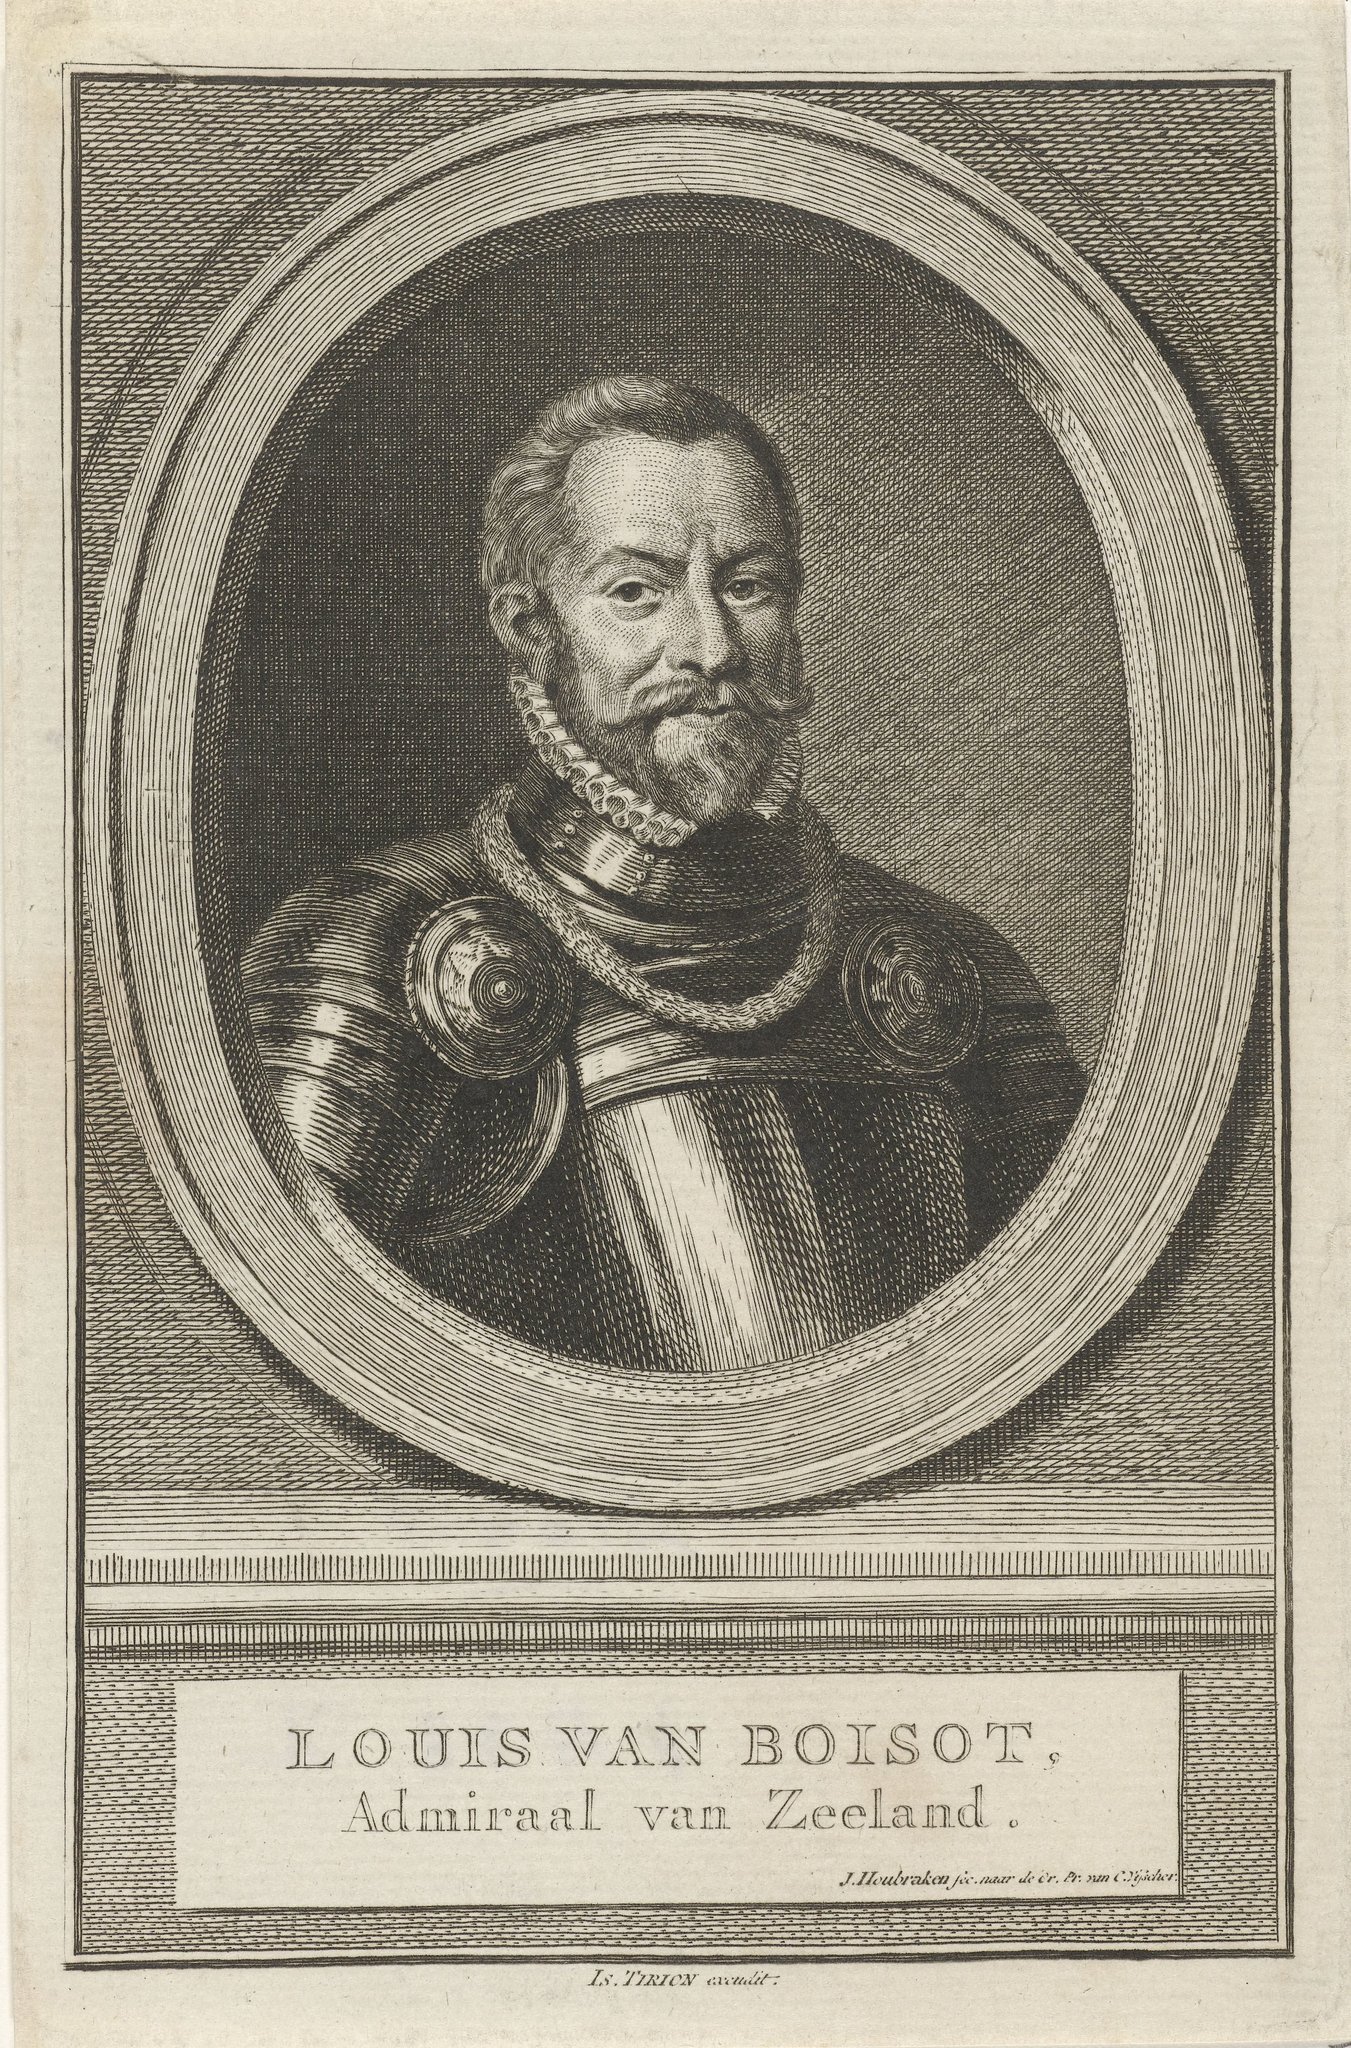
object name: print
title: Portret van Louis de Boisot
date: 1749-1759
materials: paper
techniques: engraving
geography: amsterdam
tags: brussels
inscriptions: collector's mark: Lugt 2228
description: Prent ook gebruikt in: Jan Wagenaar, Vaderlandsche historie, vervattende de geschiedenissen der nu Vereenigde Nederlanden, inzonderheid die van Holland (...), 21 delen. Amsterdam, Isaak Tirion, 1749-59. Prent volgens Ver Huell ook gebruikt in: Portraiten van eenige der vermaardste staatsmannen en zeehelden, als toevoeging op: Willem Tiberius Hattinga, Atlas van Zeeland. Amsterdam: Isaak Tirion, 1760.